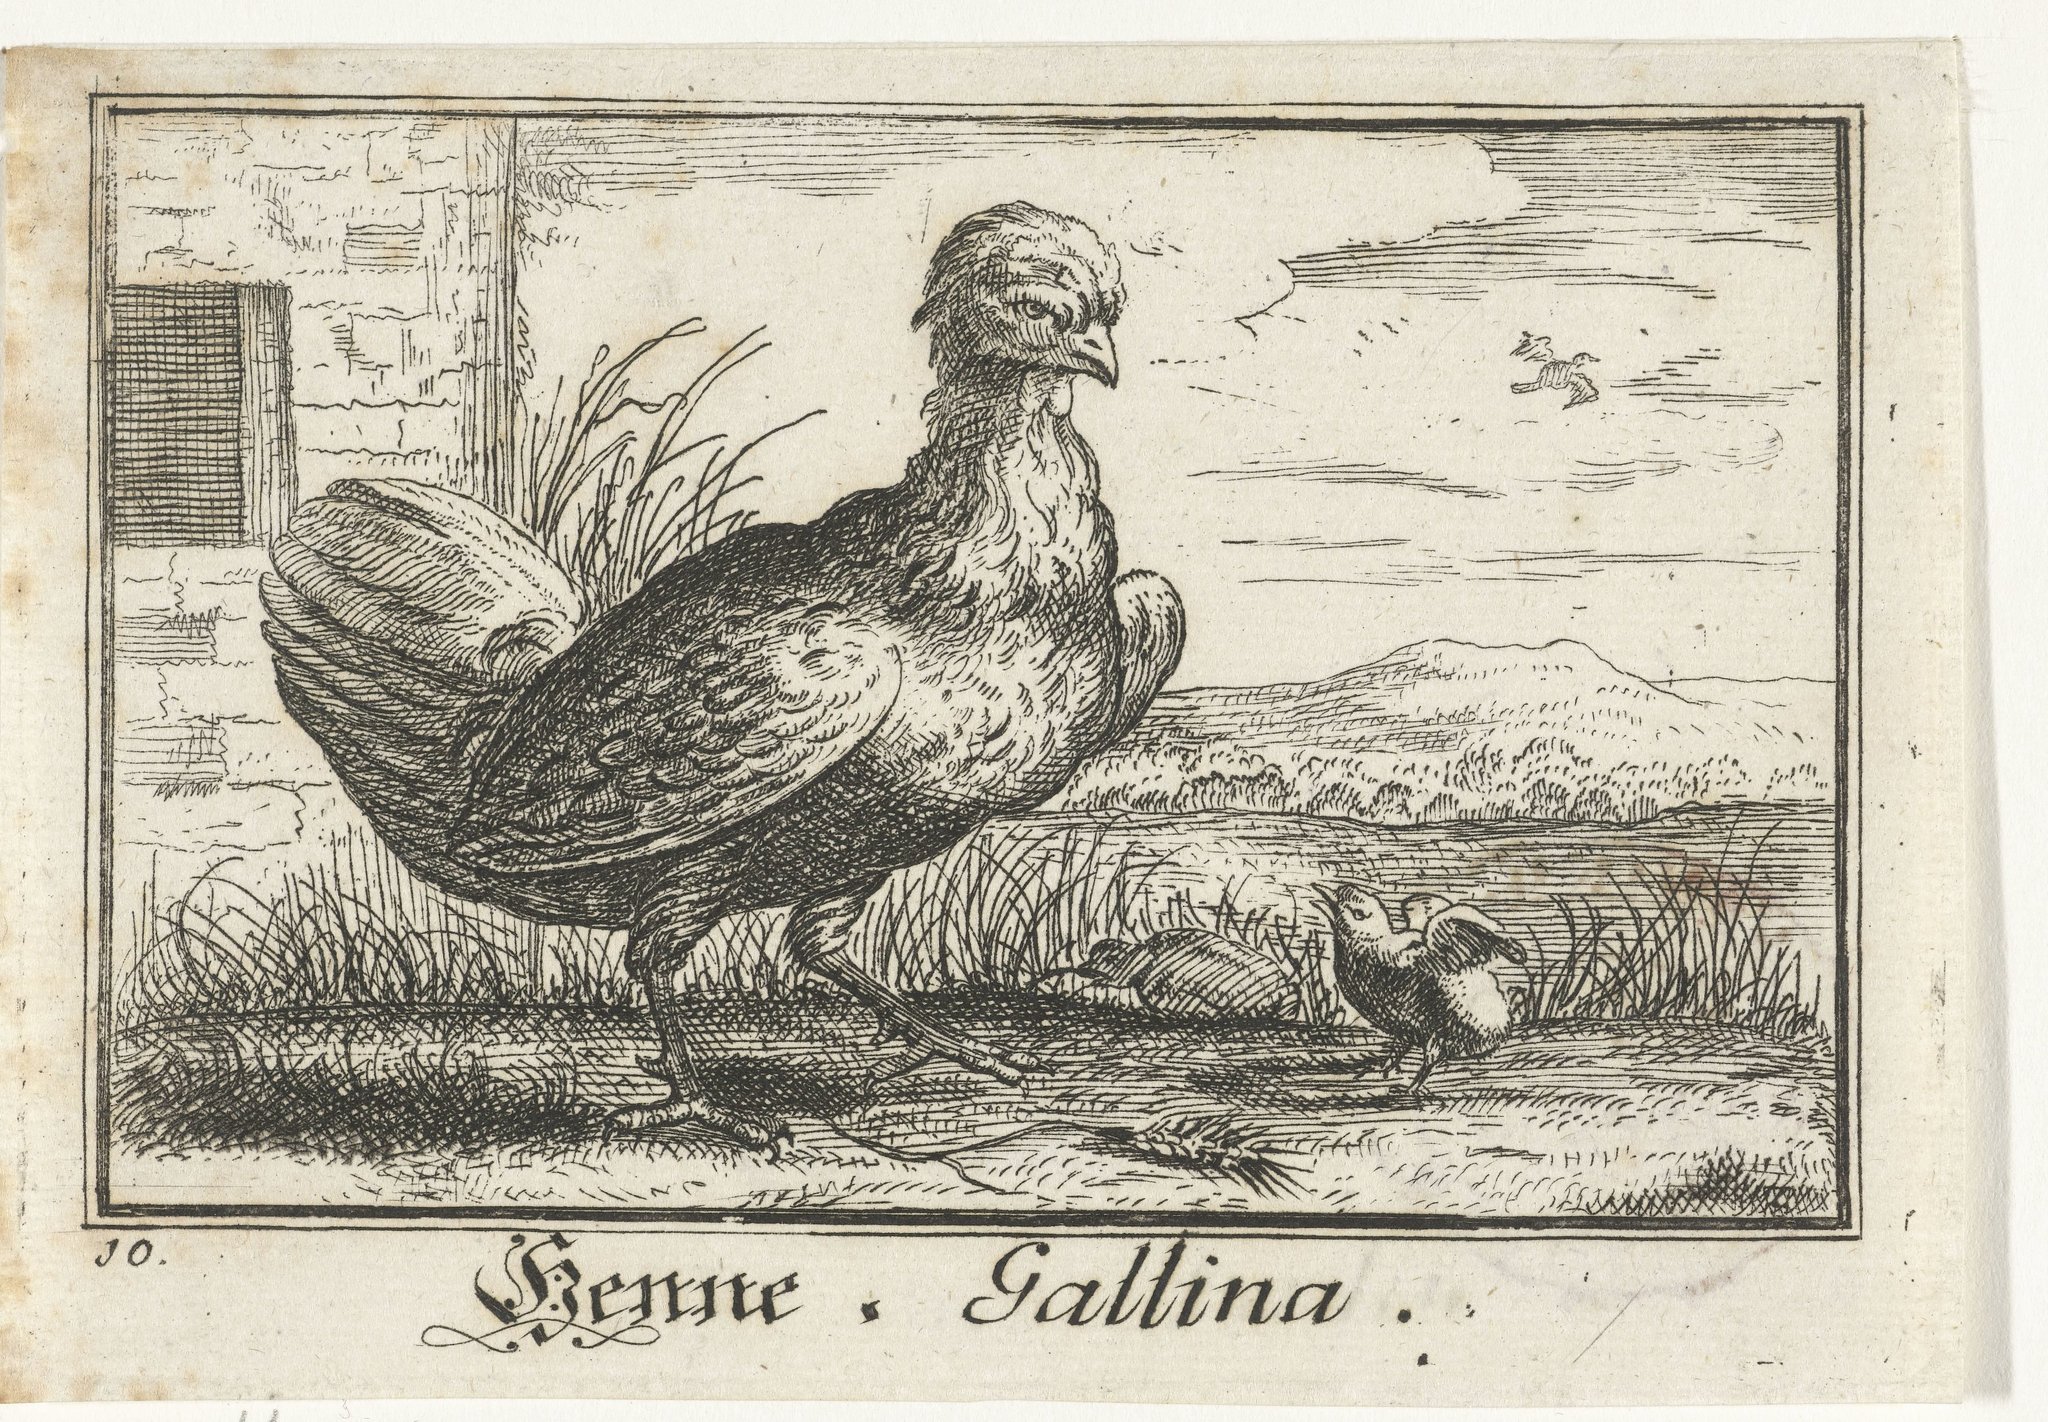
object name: print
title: Kip met kuiken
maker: Anonymous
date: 1659-1741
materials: paper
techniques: etching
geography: europe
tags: fowl (cock, hen, chicken, etc.)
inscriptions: collector's mark: Lugt 240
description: Kopie in spiegelbeeld naar een prent uit de serie Dertien vogelsoorten van Albert Flamen.